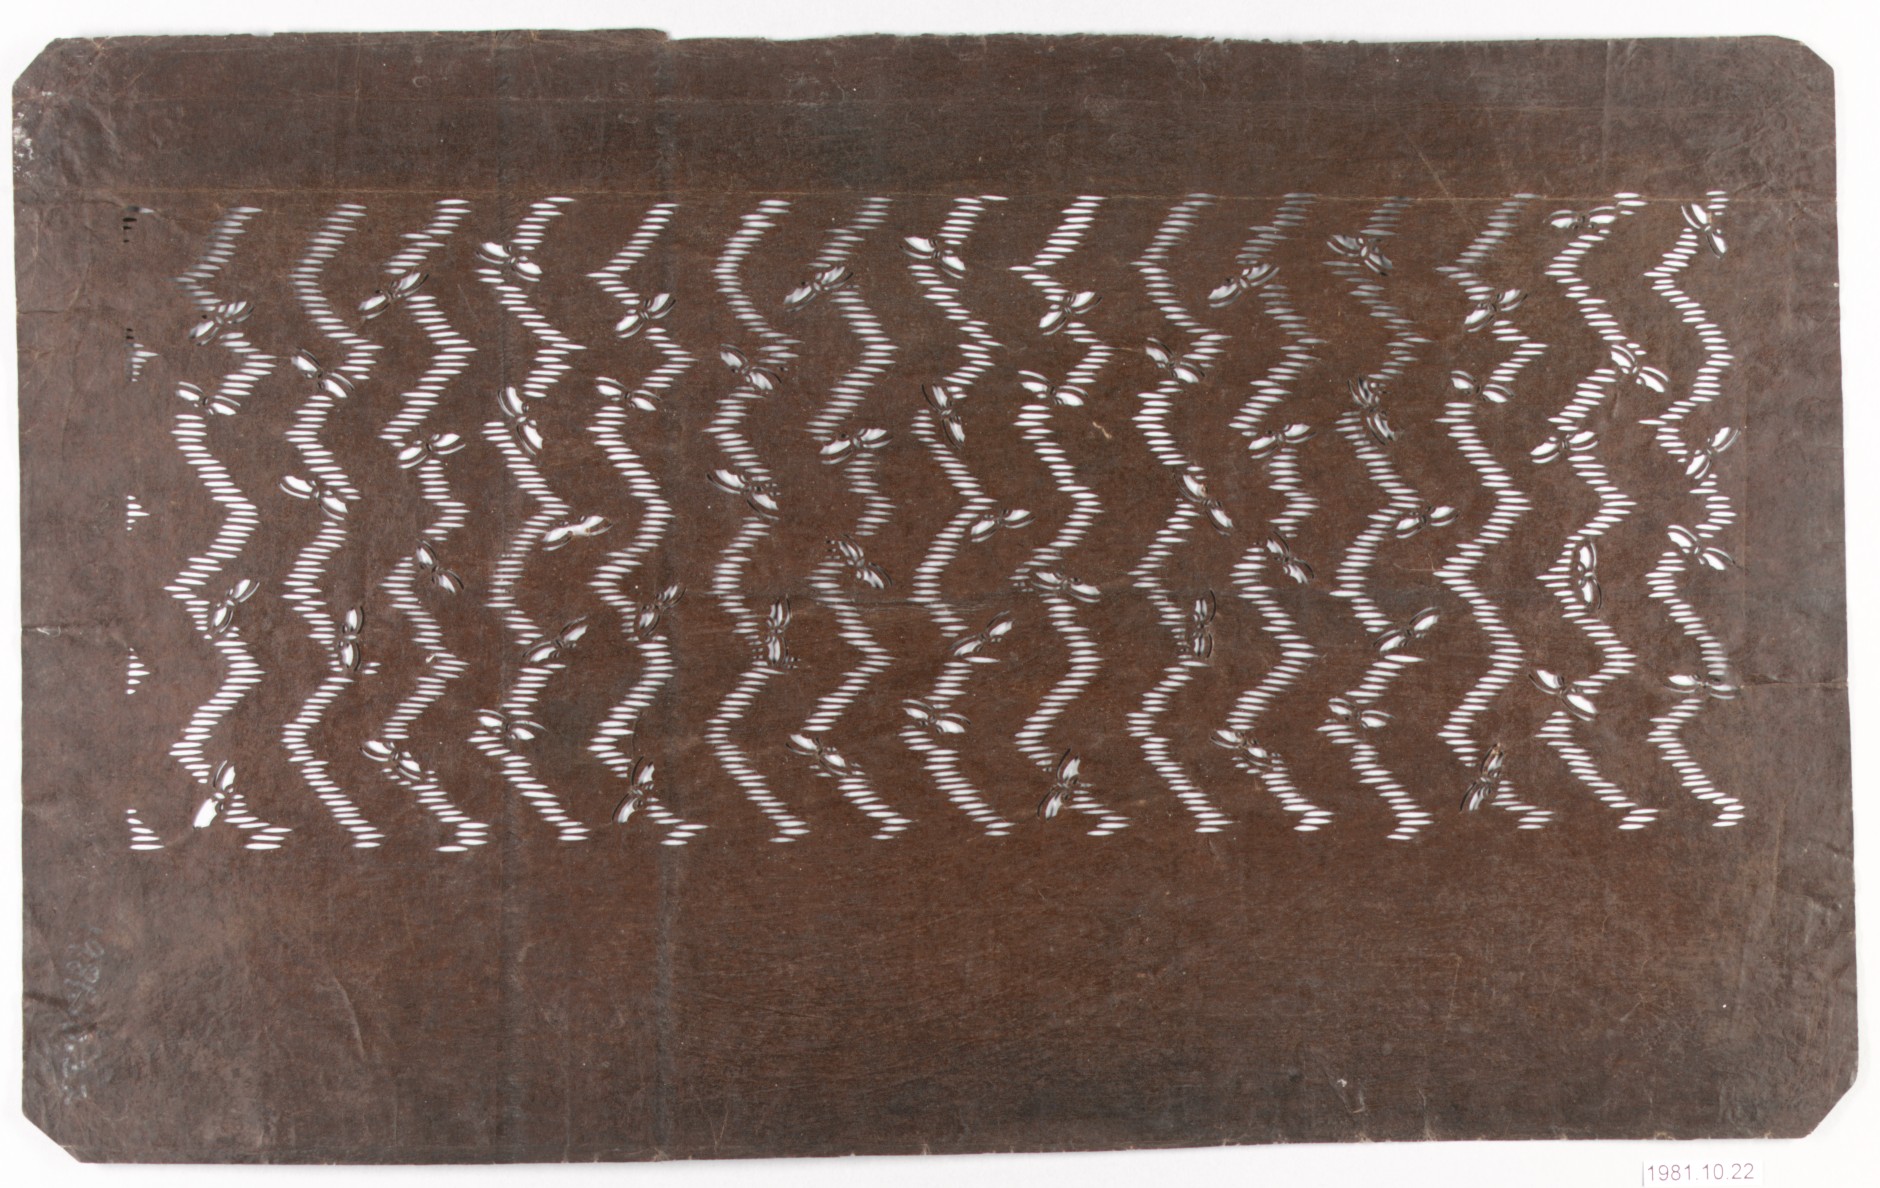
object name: stencil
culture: japanese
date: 1801-1900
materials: paper